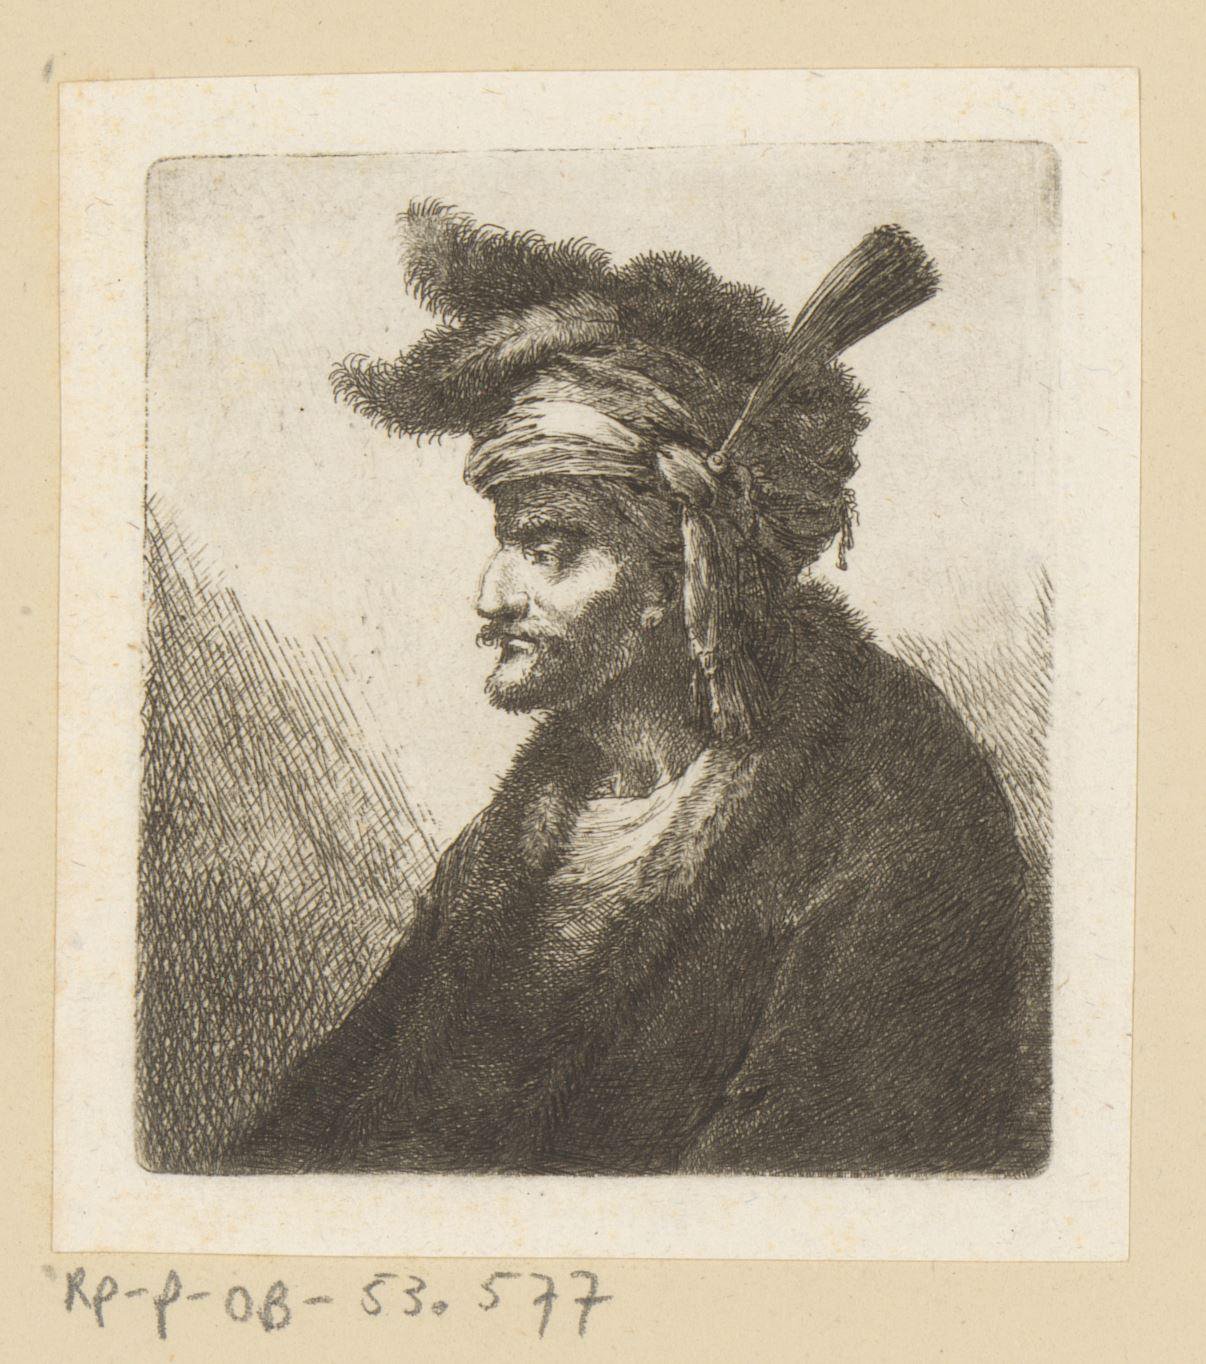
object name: print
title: Man met muts met veren en pluim en profile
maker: johann andreas benjamin nothnagel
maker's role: print maker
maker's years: 1729-1804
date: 1776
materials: paper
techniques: etching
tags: head-gear: cap (+ men's clothes), adult man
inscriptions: collector's mark: Lugt 240